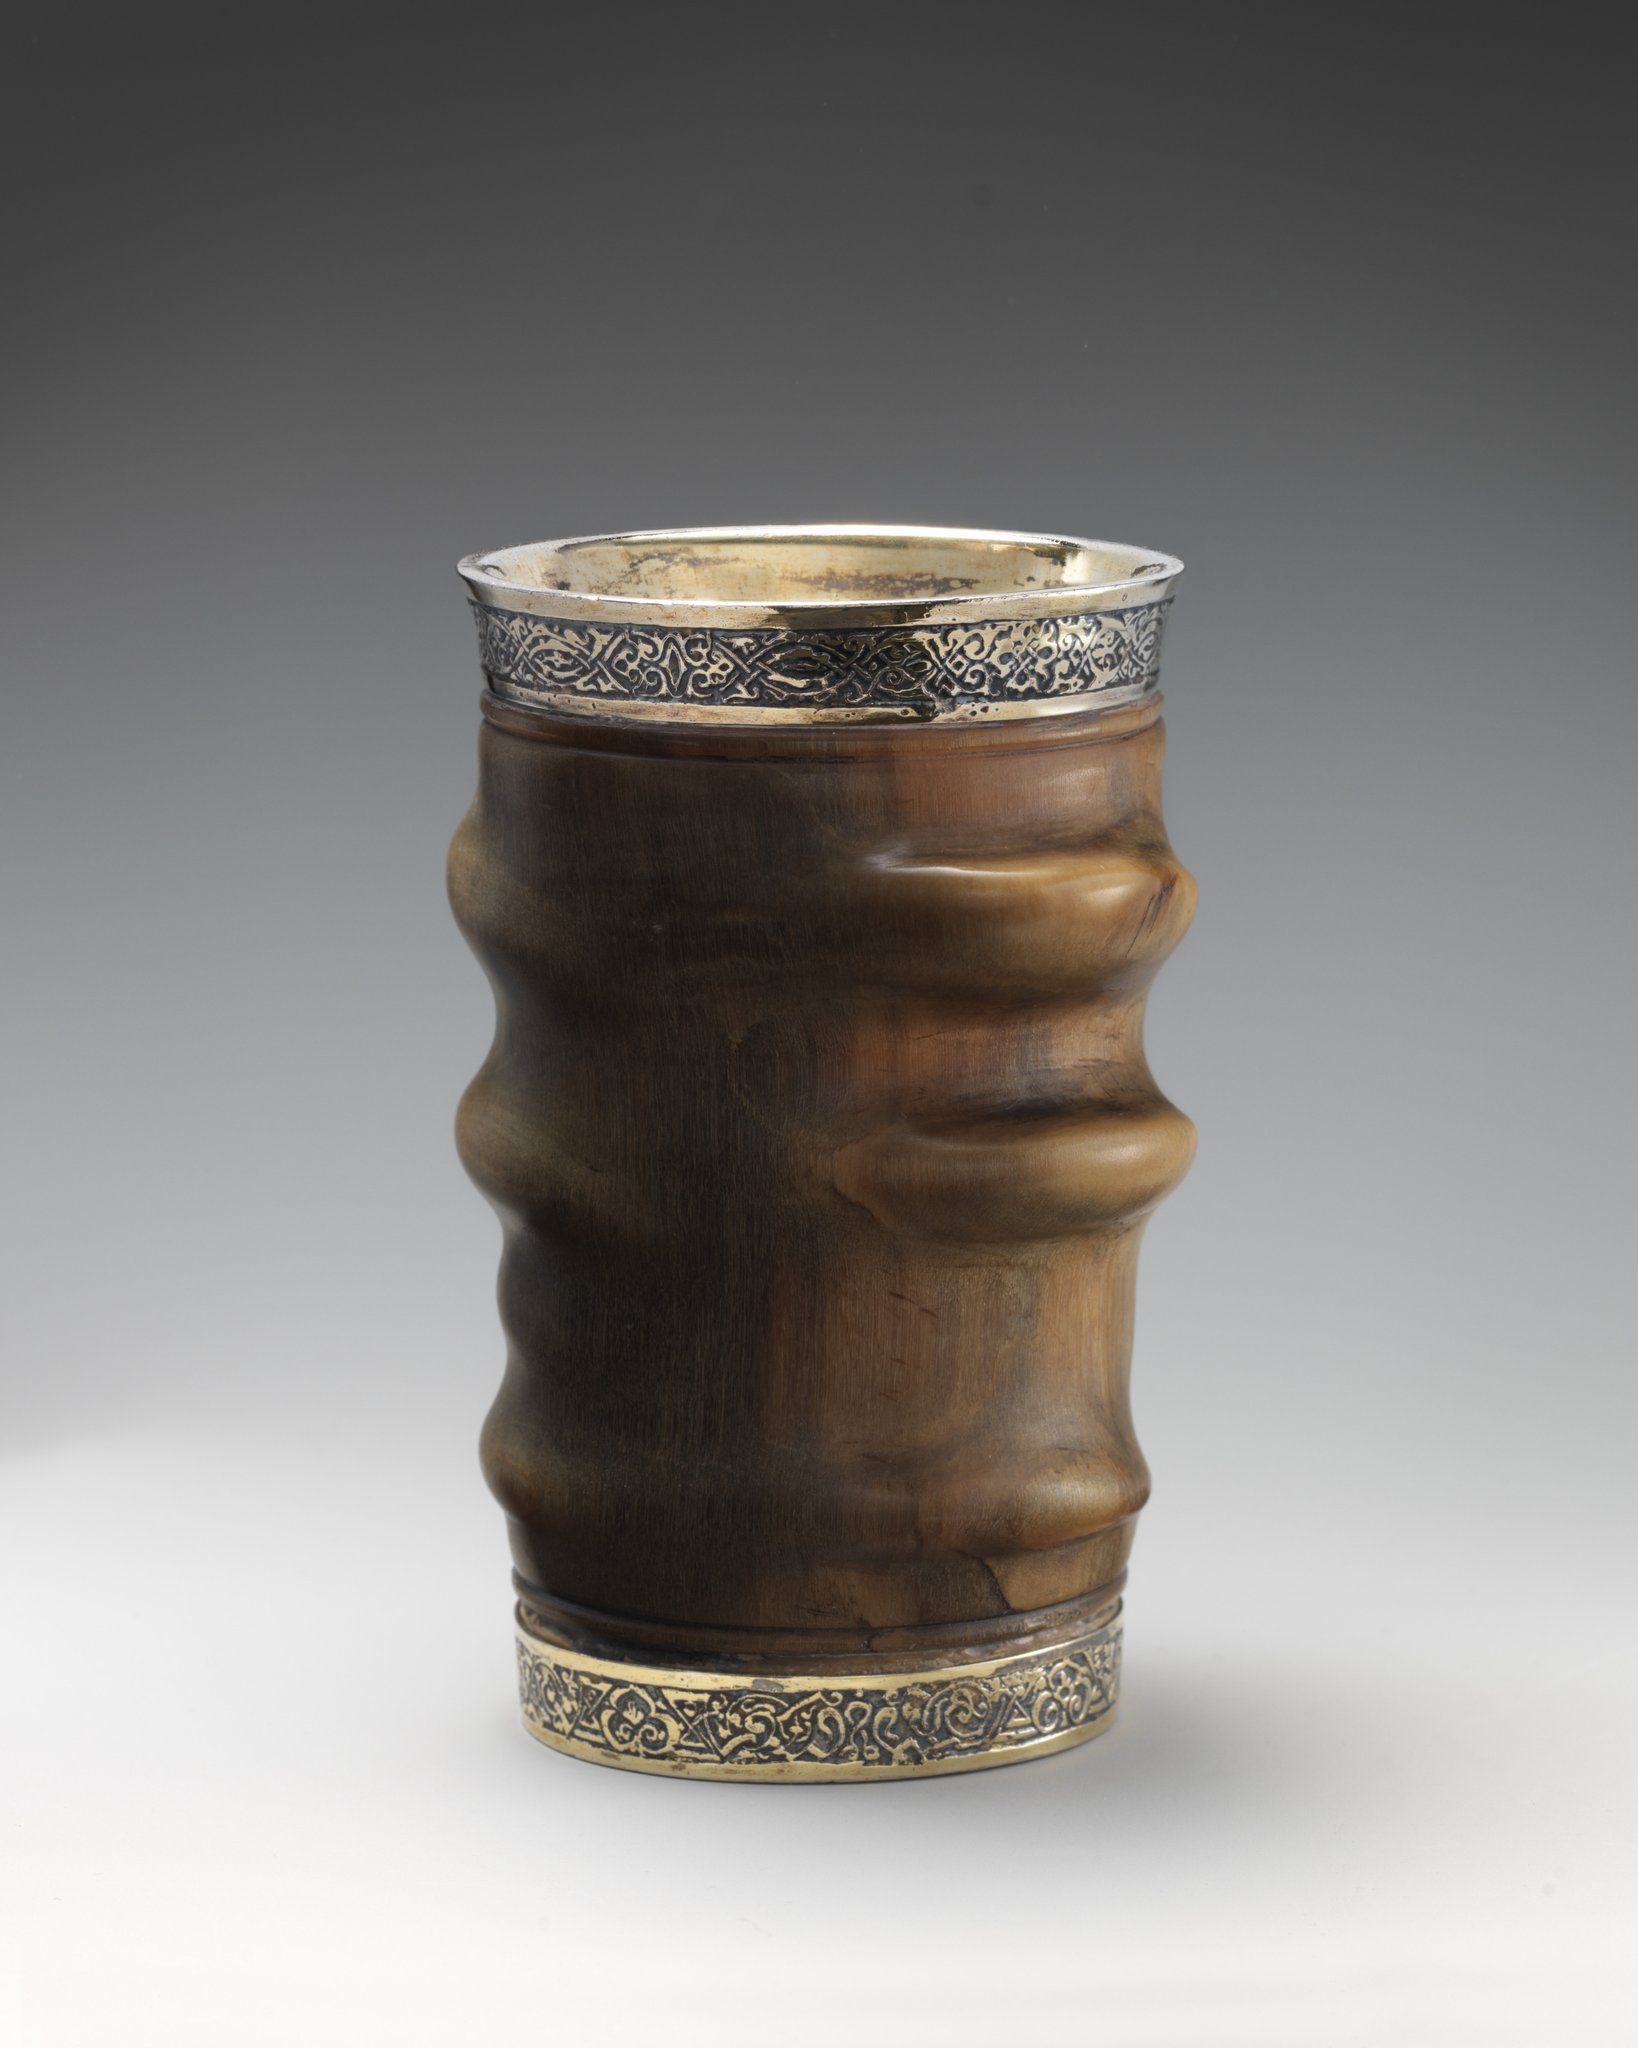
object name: beaker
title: Ibex beaker with gilded silver mounts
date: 1600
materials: gilt silver, horn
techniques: carving, polish